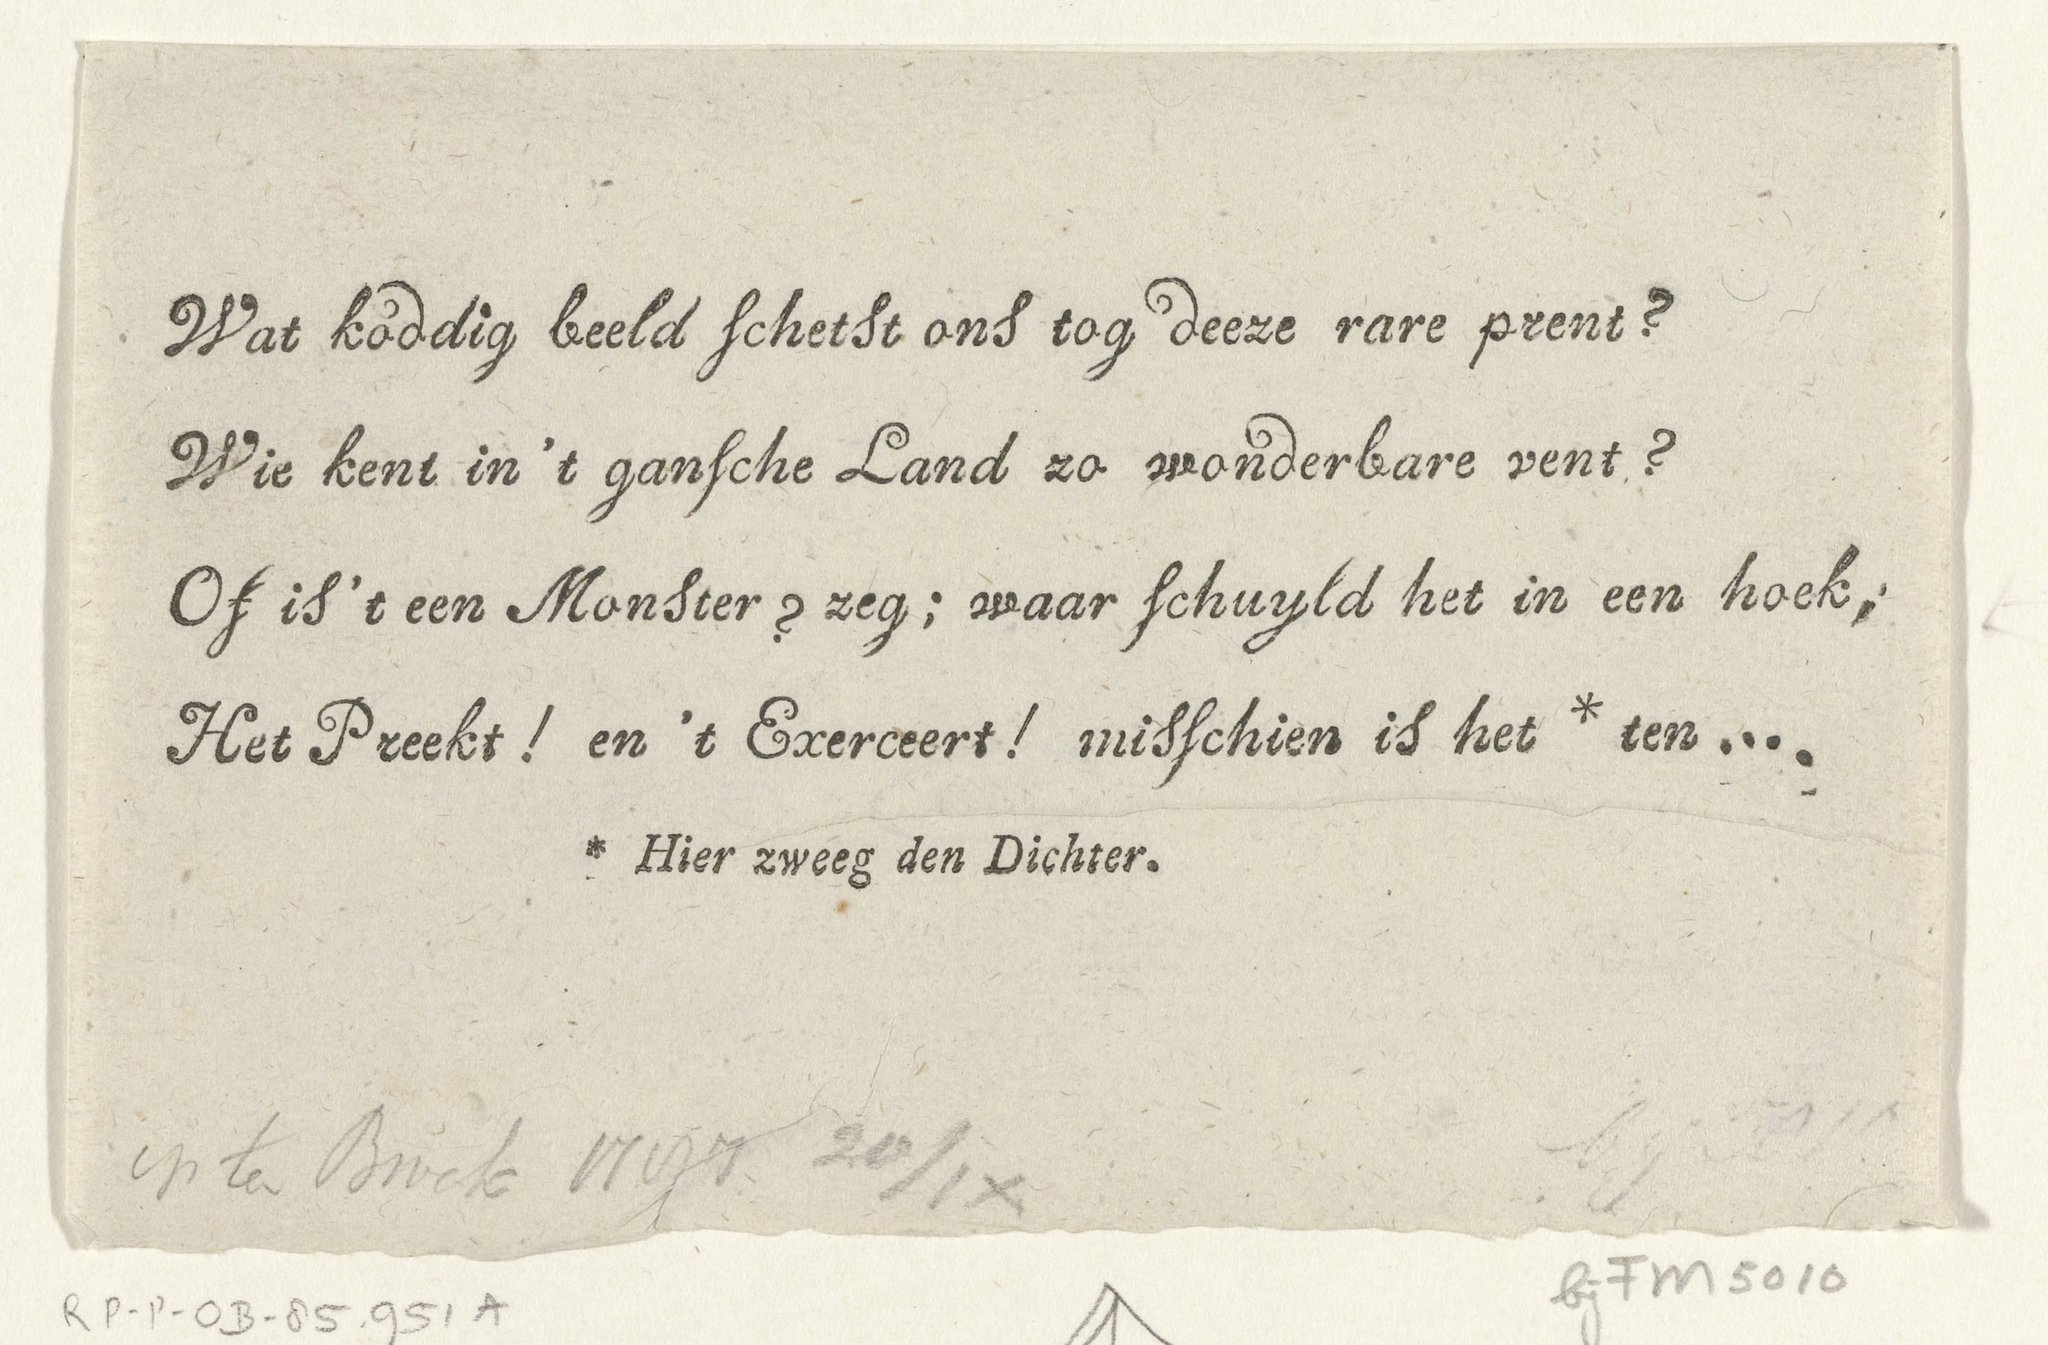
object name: text sheet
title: Tekstblad bij de spotprent op Johan Jacob le Sage ten Broek, 1787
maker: Anonymous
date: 1787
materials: paper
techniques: letterpress printing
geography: northern netherlands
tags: the hague, rotterdam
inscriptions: collector's mark: Lugt 2228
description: Tekstblad bij de spotprent op de, na het herstel van de prins van Oranje, door het Rotterdamse stadsbestuur ontslagen patriotse predikant Johan Jacob le Sage ten Broek, oktober 1787. Vers van vier regels.